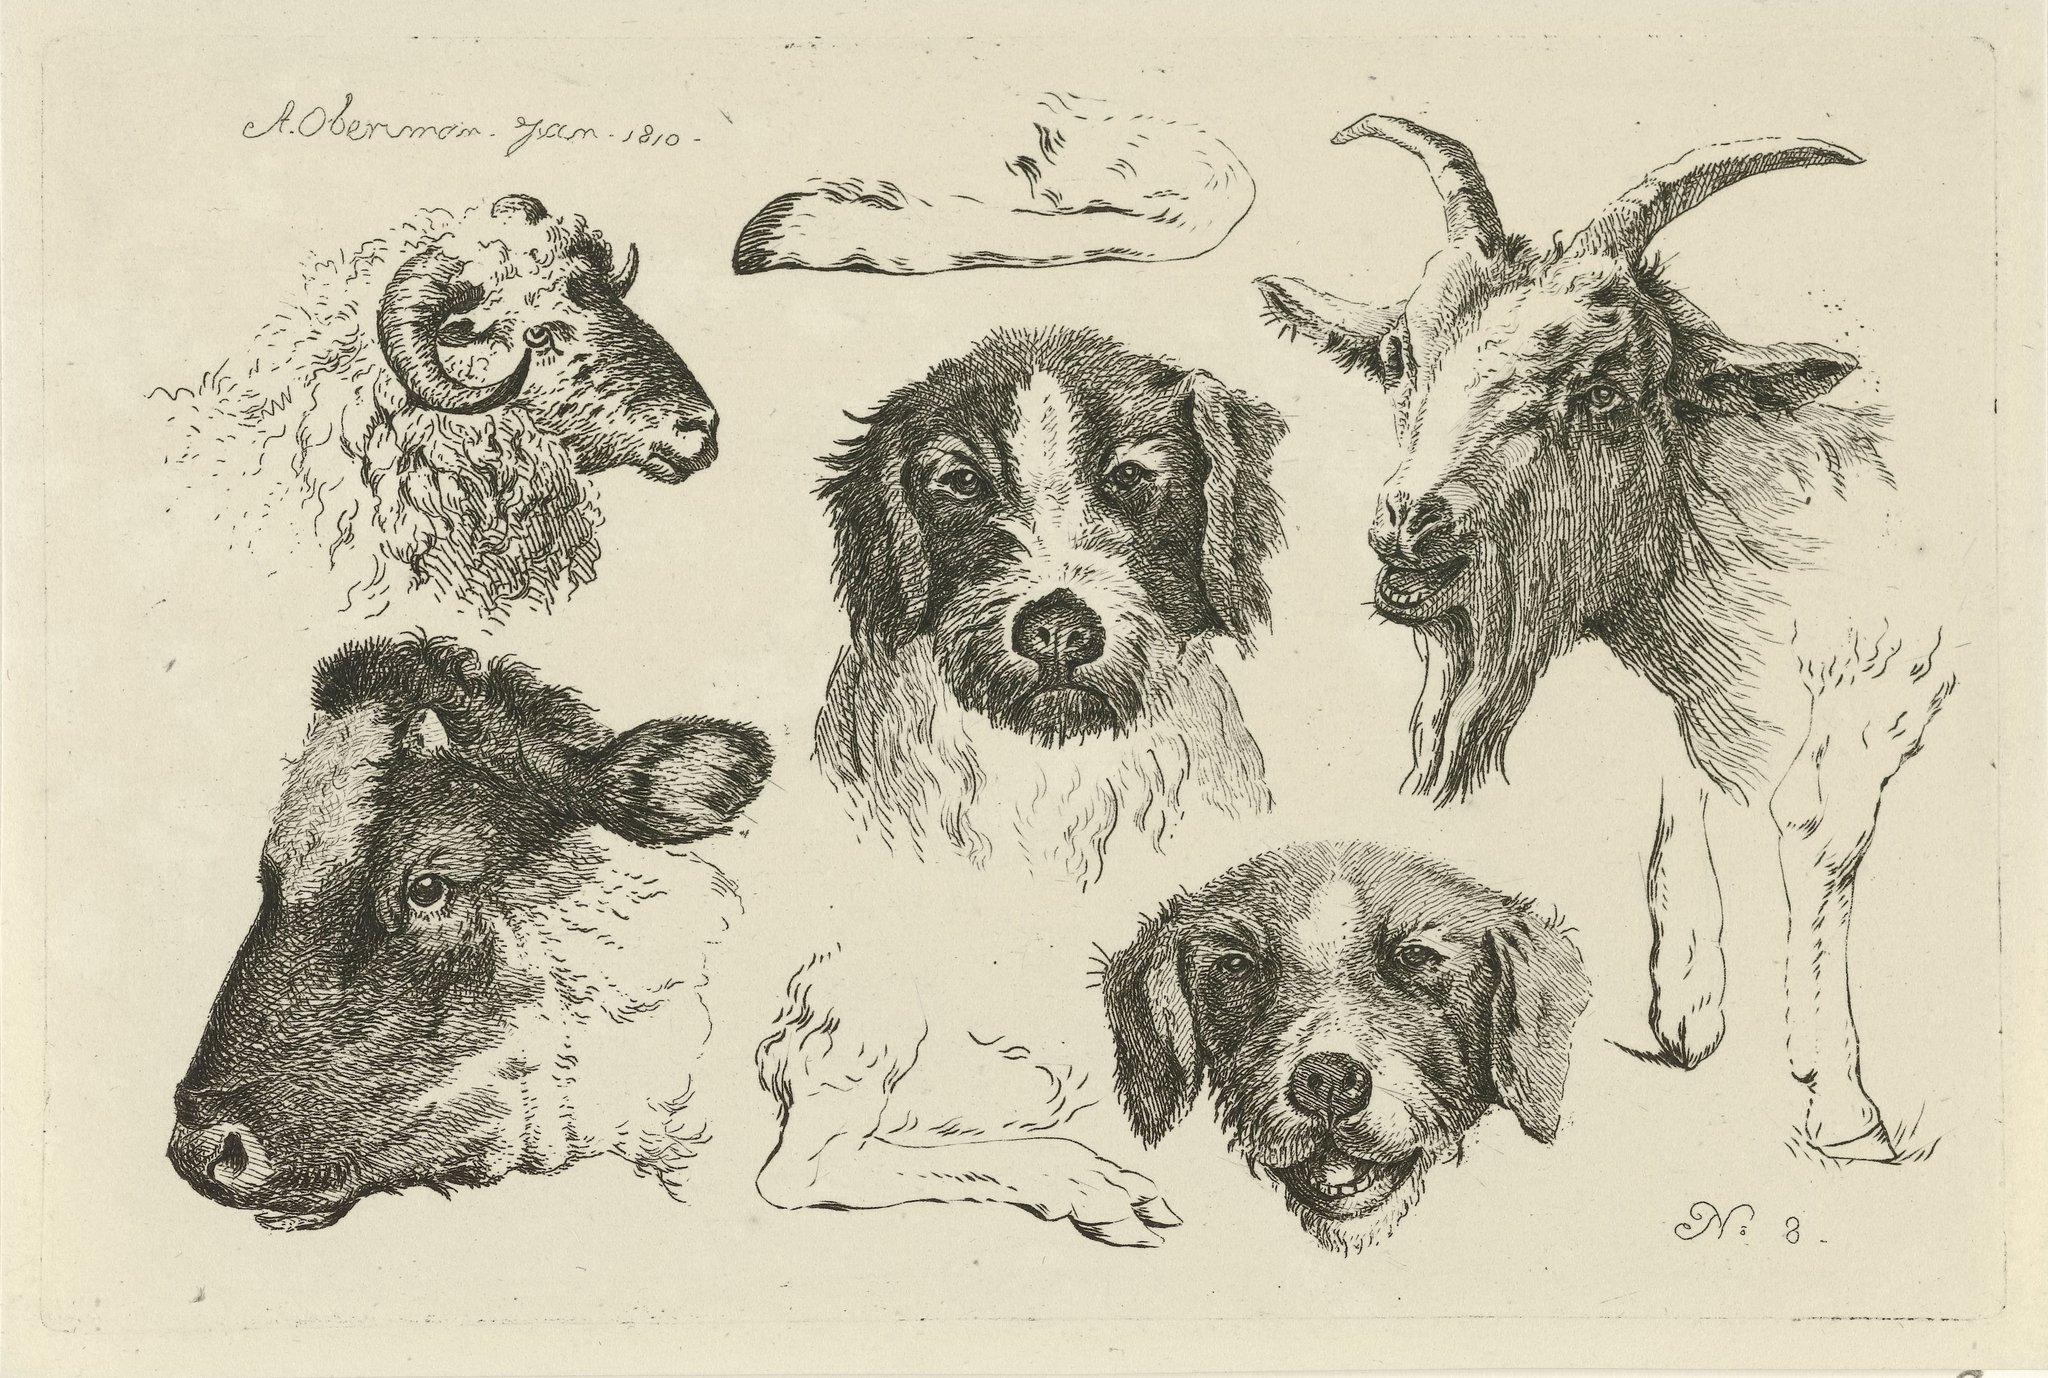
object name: print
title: Studies van koeien, schapen en geiten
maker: anthony oberman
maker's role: draughtsman, painter, print maker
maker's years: 1781-1845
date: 1801-1810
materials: paper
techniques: etching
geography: amsterdam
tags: cattle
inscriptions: collector's mark: Lugt 2228